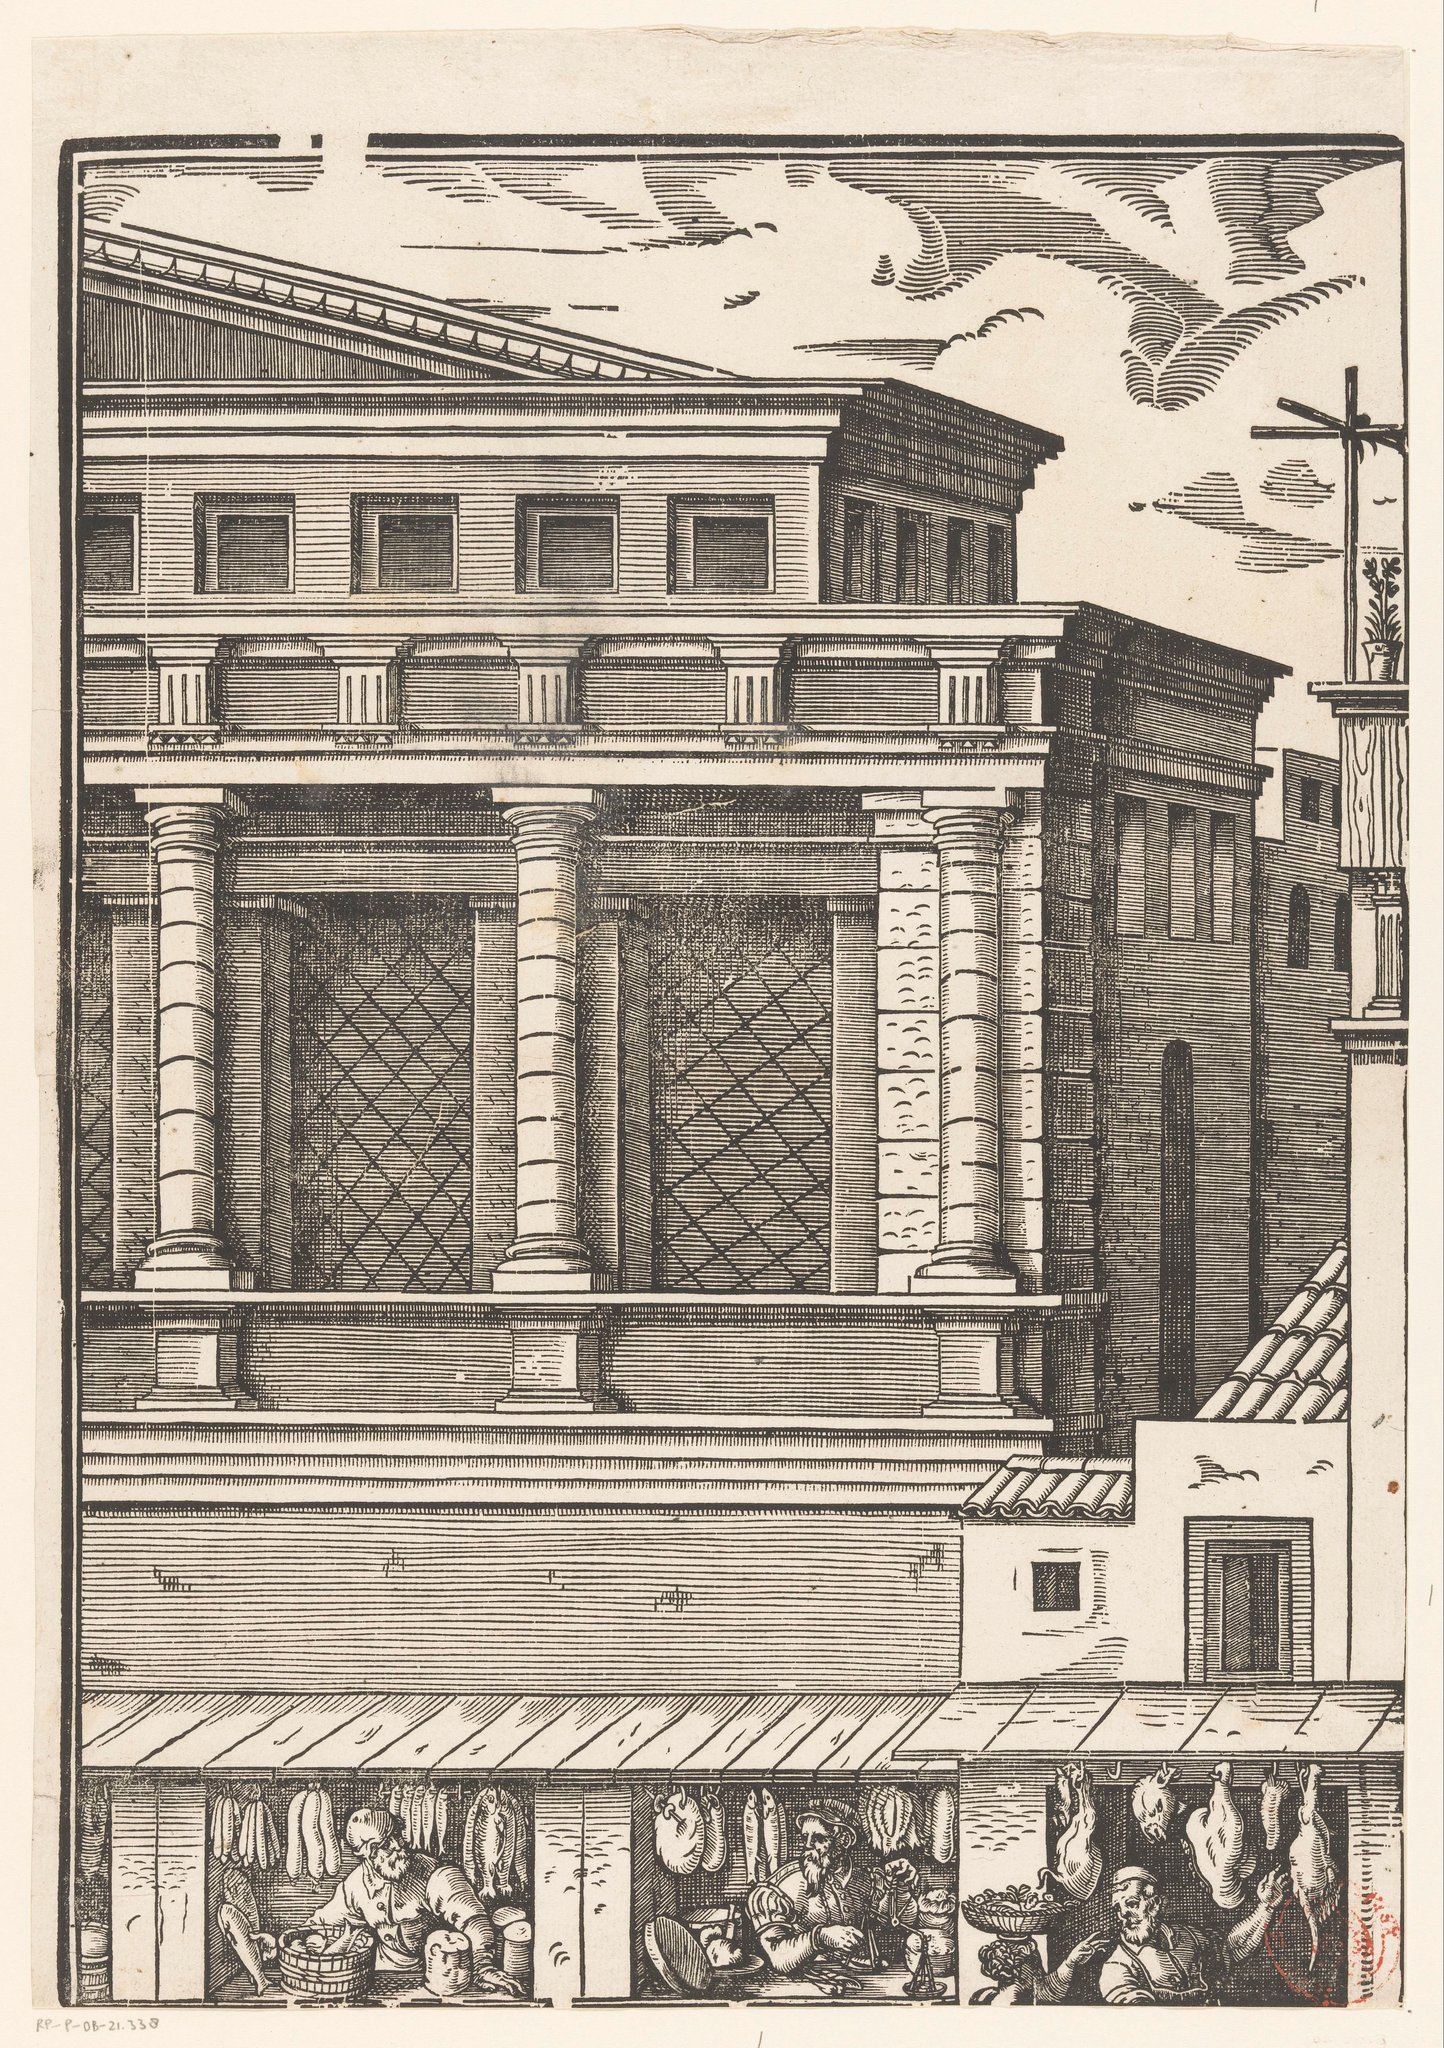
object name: print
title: Ankunfft Und herkommen der weitberümbten herrlichen Statt Venedig Sambt derselben gewaltigen Herrschafft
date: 1679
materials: paper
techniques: woodcut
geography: nuremberg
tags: city-view in general; 'veduta', procession ~ christian religion, gondola, merchant, salesman, venice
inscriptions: collector's mark: Lugt 240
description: Eerste gedeelte van een grote voorstelling van de Festa della Sensa. De voorstelling is gedrukt van veertien blokken, de titel van vijf blokken en het onderschrift bestaat uit vijf delen van elk drie kolommen Duits tekst. De veertien blokken die samen de voorstelling vormen zijn in de titels met de klok mee vanaf linksboven genummerd. In de collectie Rijksmuseum bevinden zich twee complete exemplaren inclusief titel en onderschrift. Omdat niet alle delen van de titel en het onderschrift op afzonderlijke bladen zijn gedrukt, is dit exemplaar niet virtueel samengevoegd omwille van een betere presentatie. Zie voor het andere exemplaar: RP-P-2017-6073.